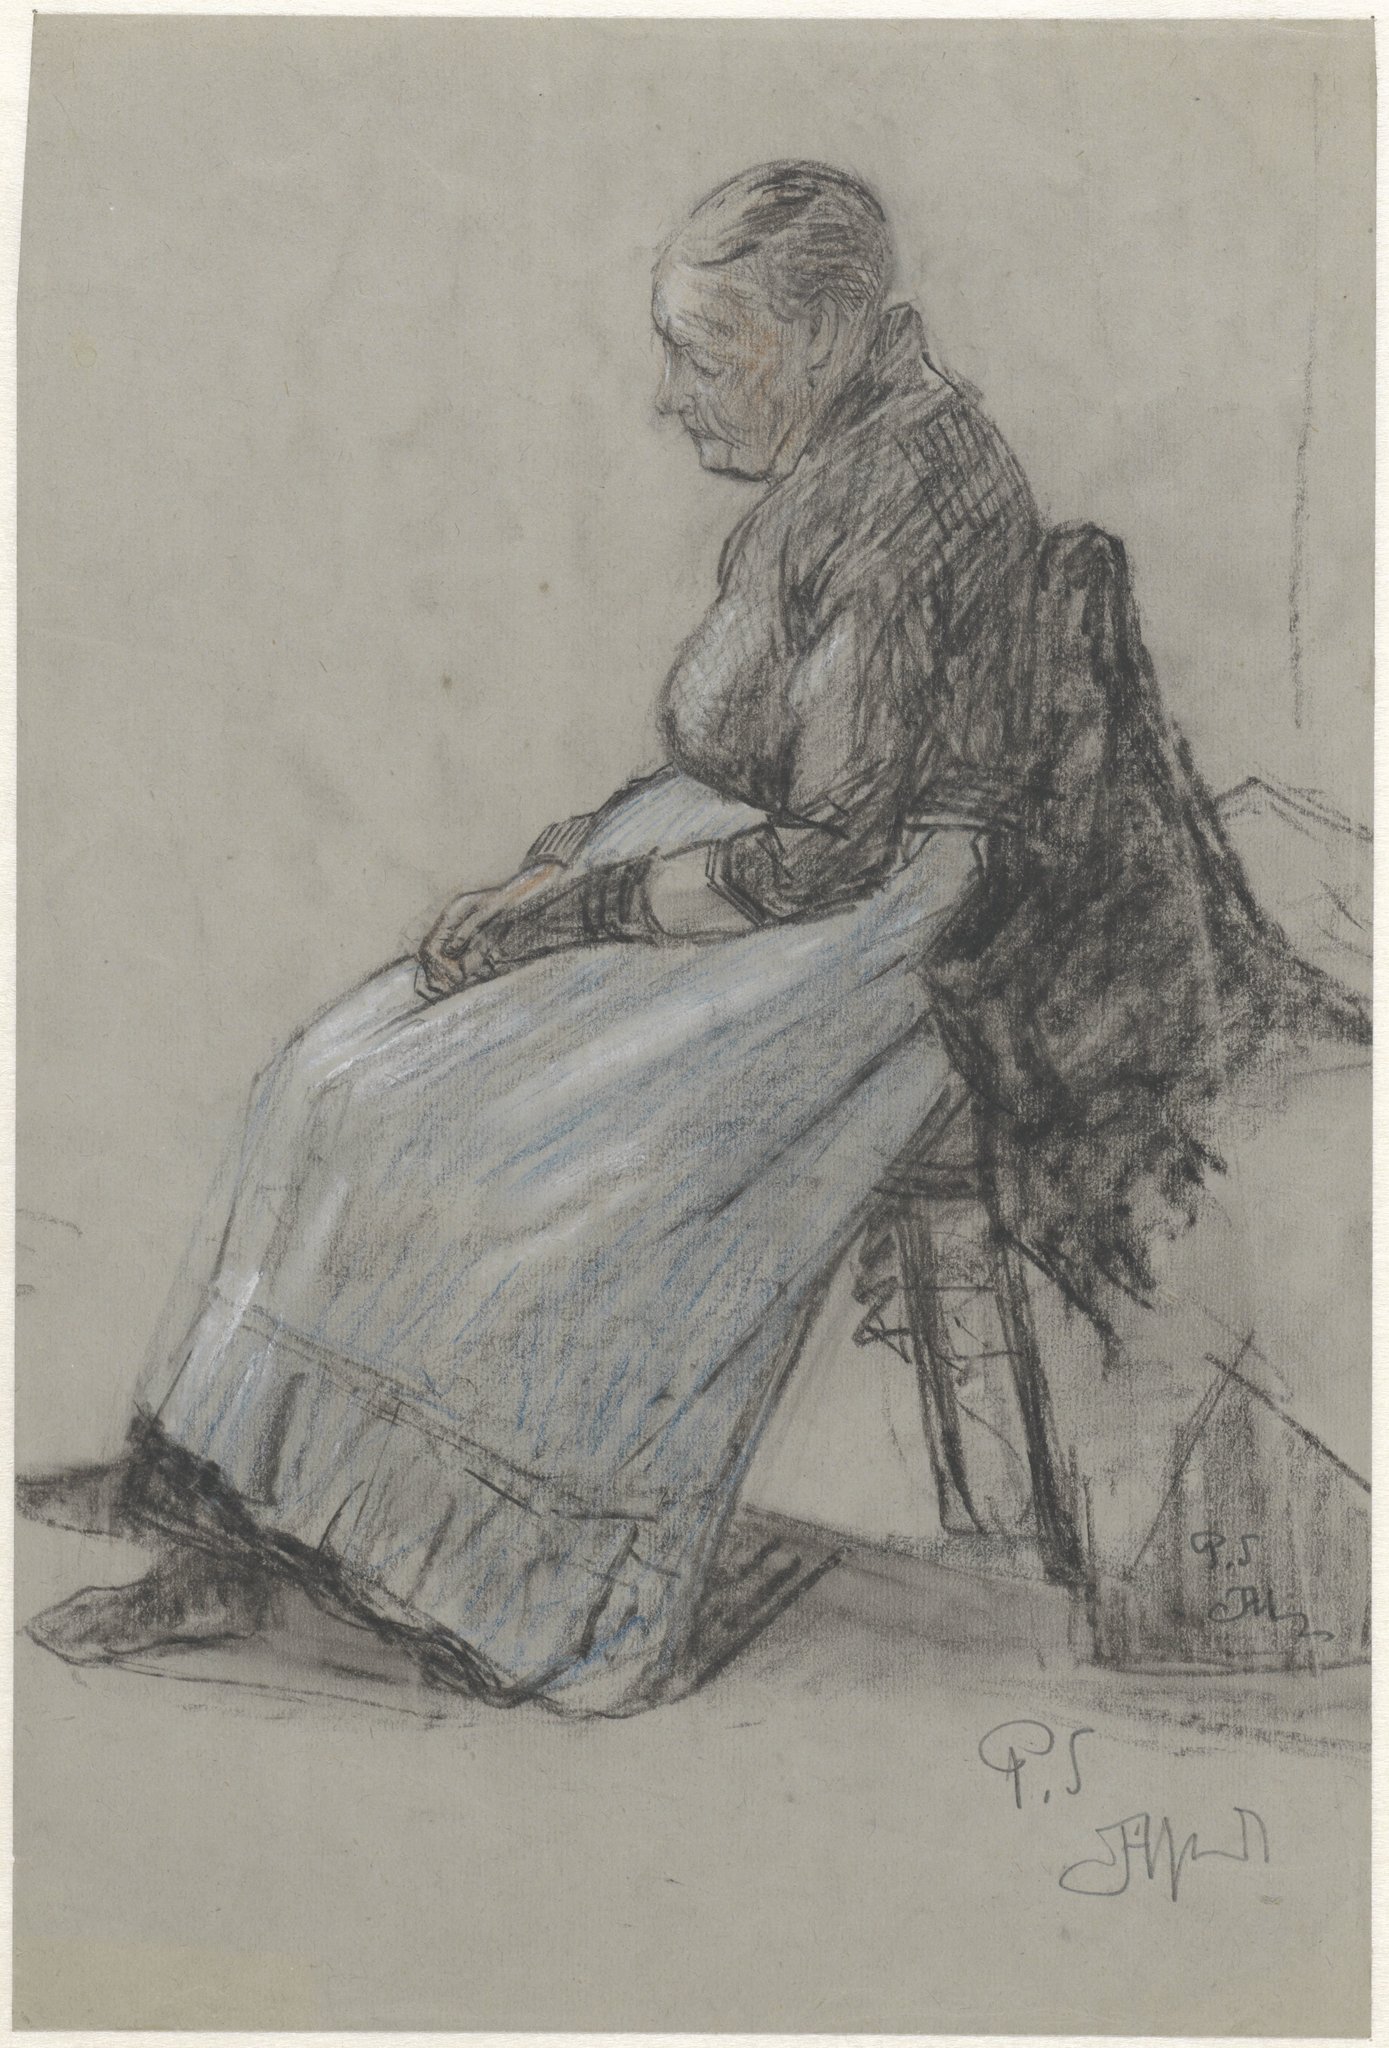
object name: drawing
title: Zittende oudere vrouw, naar links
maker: johannes abraham mondt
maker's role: draughtsman, print maker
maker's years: 1859-1941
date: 1869-1941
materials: chalk, paper